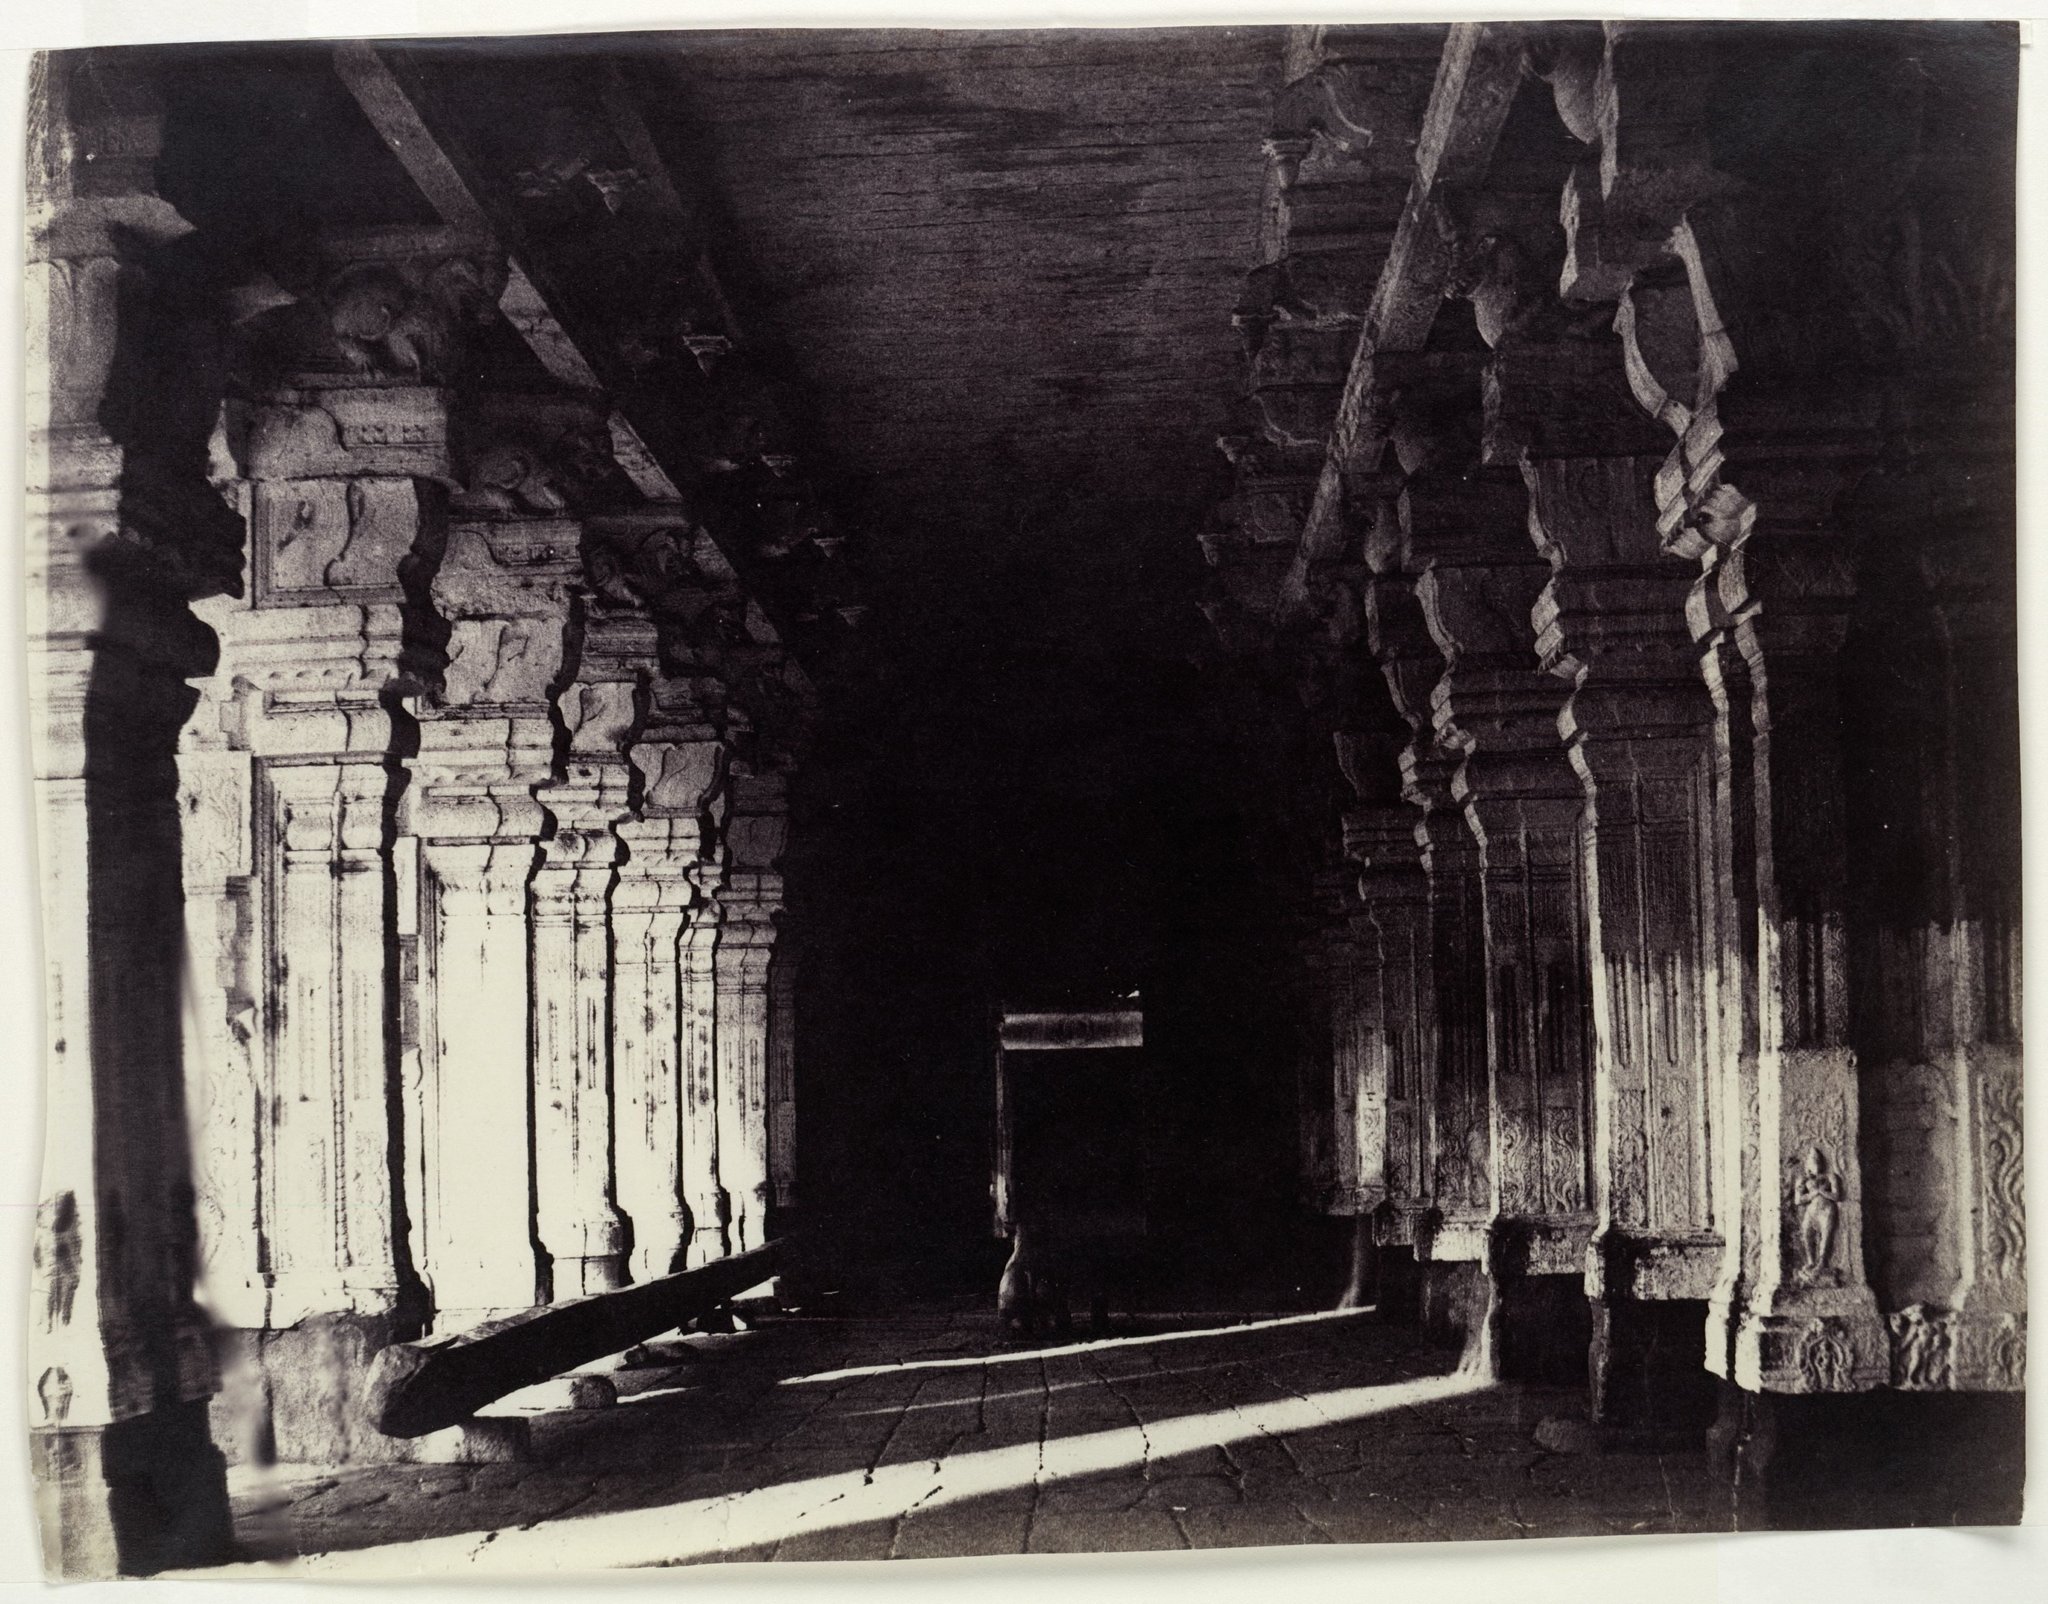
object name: photograph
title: Arcade at the Meenakshi temple in Madurai, Tamil Nadu, India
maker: linnaeus tripe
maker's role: fotograaf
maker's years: 1822-1902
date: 1858-1860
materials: paper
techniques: albumen print, salted paper print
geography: madurai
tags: temple, shrine ~ hinduism, buddhism, jainism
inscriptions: inscription: ‘In-lay with (klusel?) G 3%’, inscription: ‘LT’